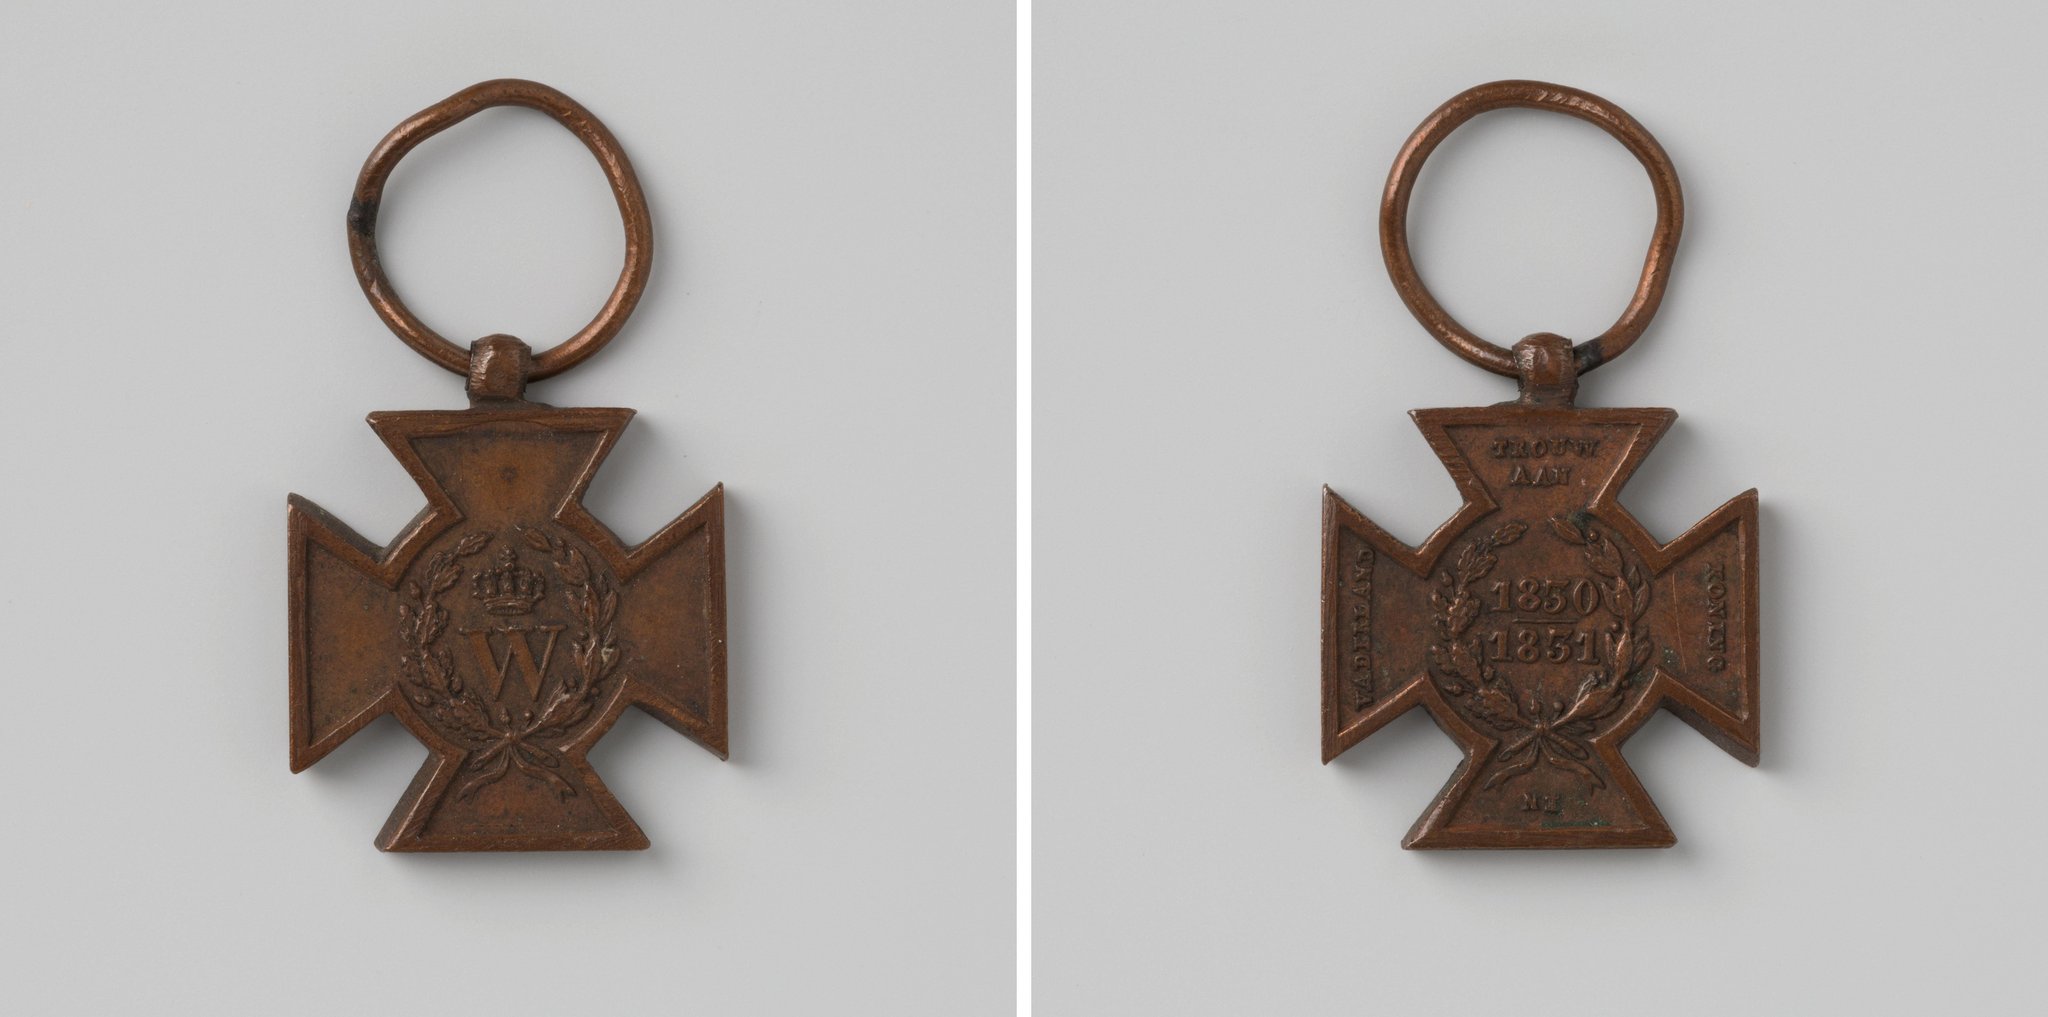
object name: draagpenning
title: Metalen Kruis, miniatuur 14 mm, 1831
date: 1831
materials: bronze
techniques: striking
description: Bronzen kruis met bal en draagring, op de voorzijde een gekroonde letter W tussen samengestrikte eiken- en lauwertakken, op de keerzijde 1830-1831 tussen samengestrikte eiken- en lauwertakken, op de benen TROUW AAN - KONING - EN - VADERLAND